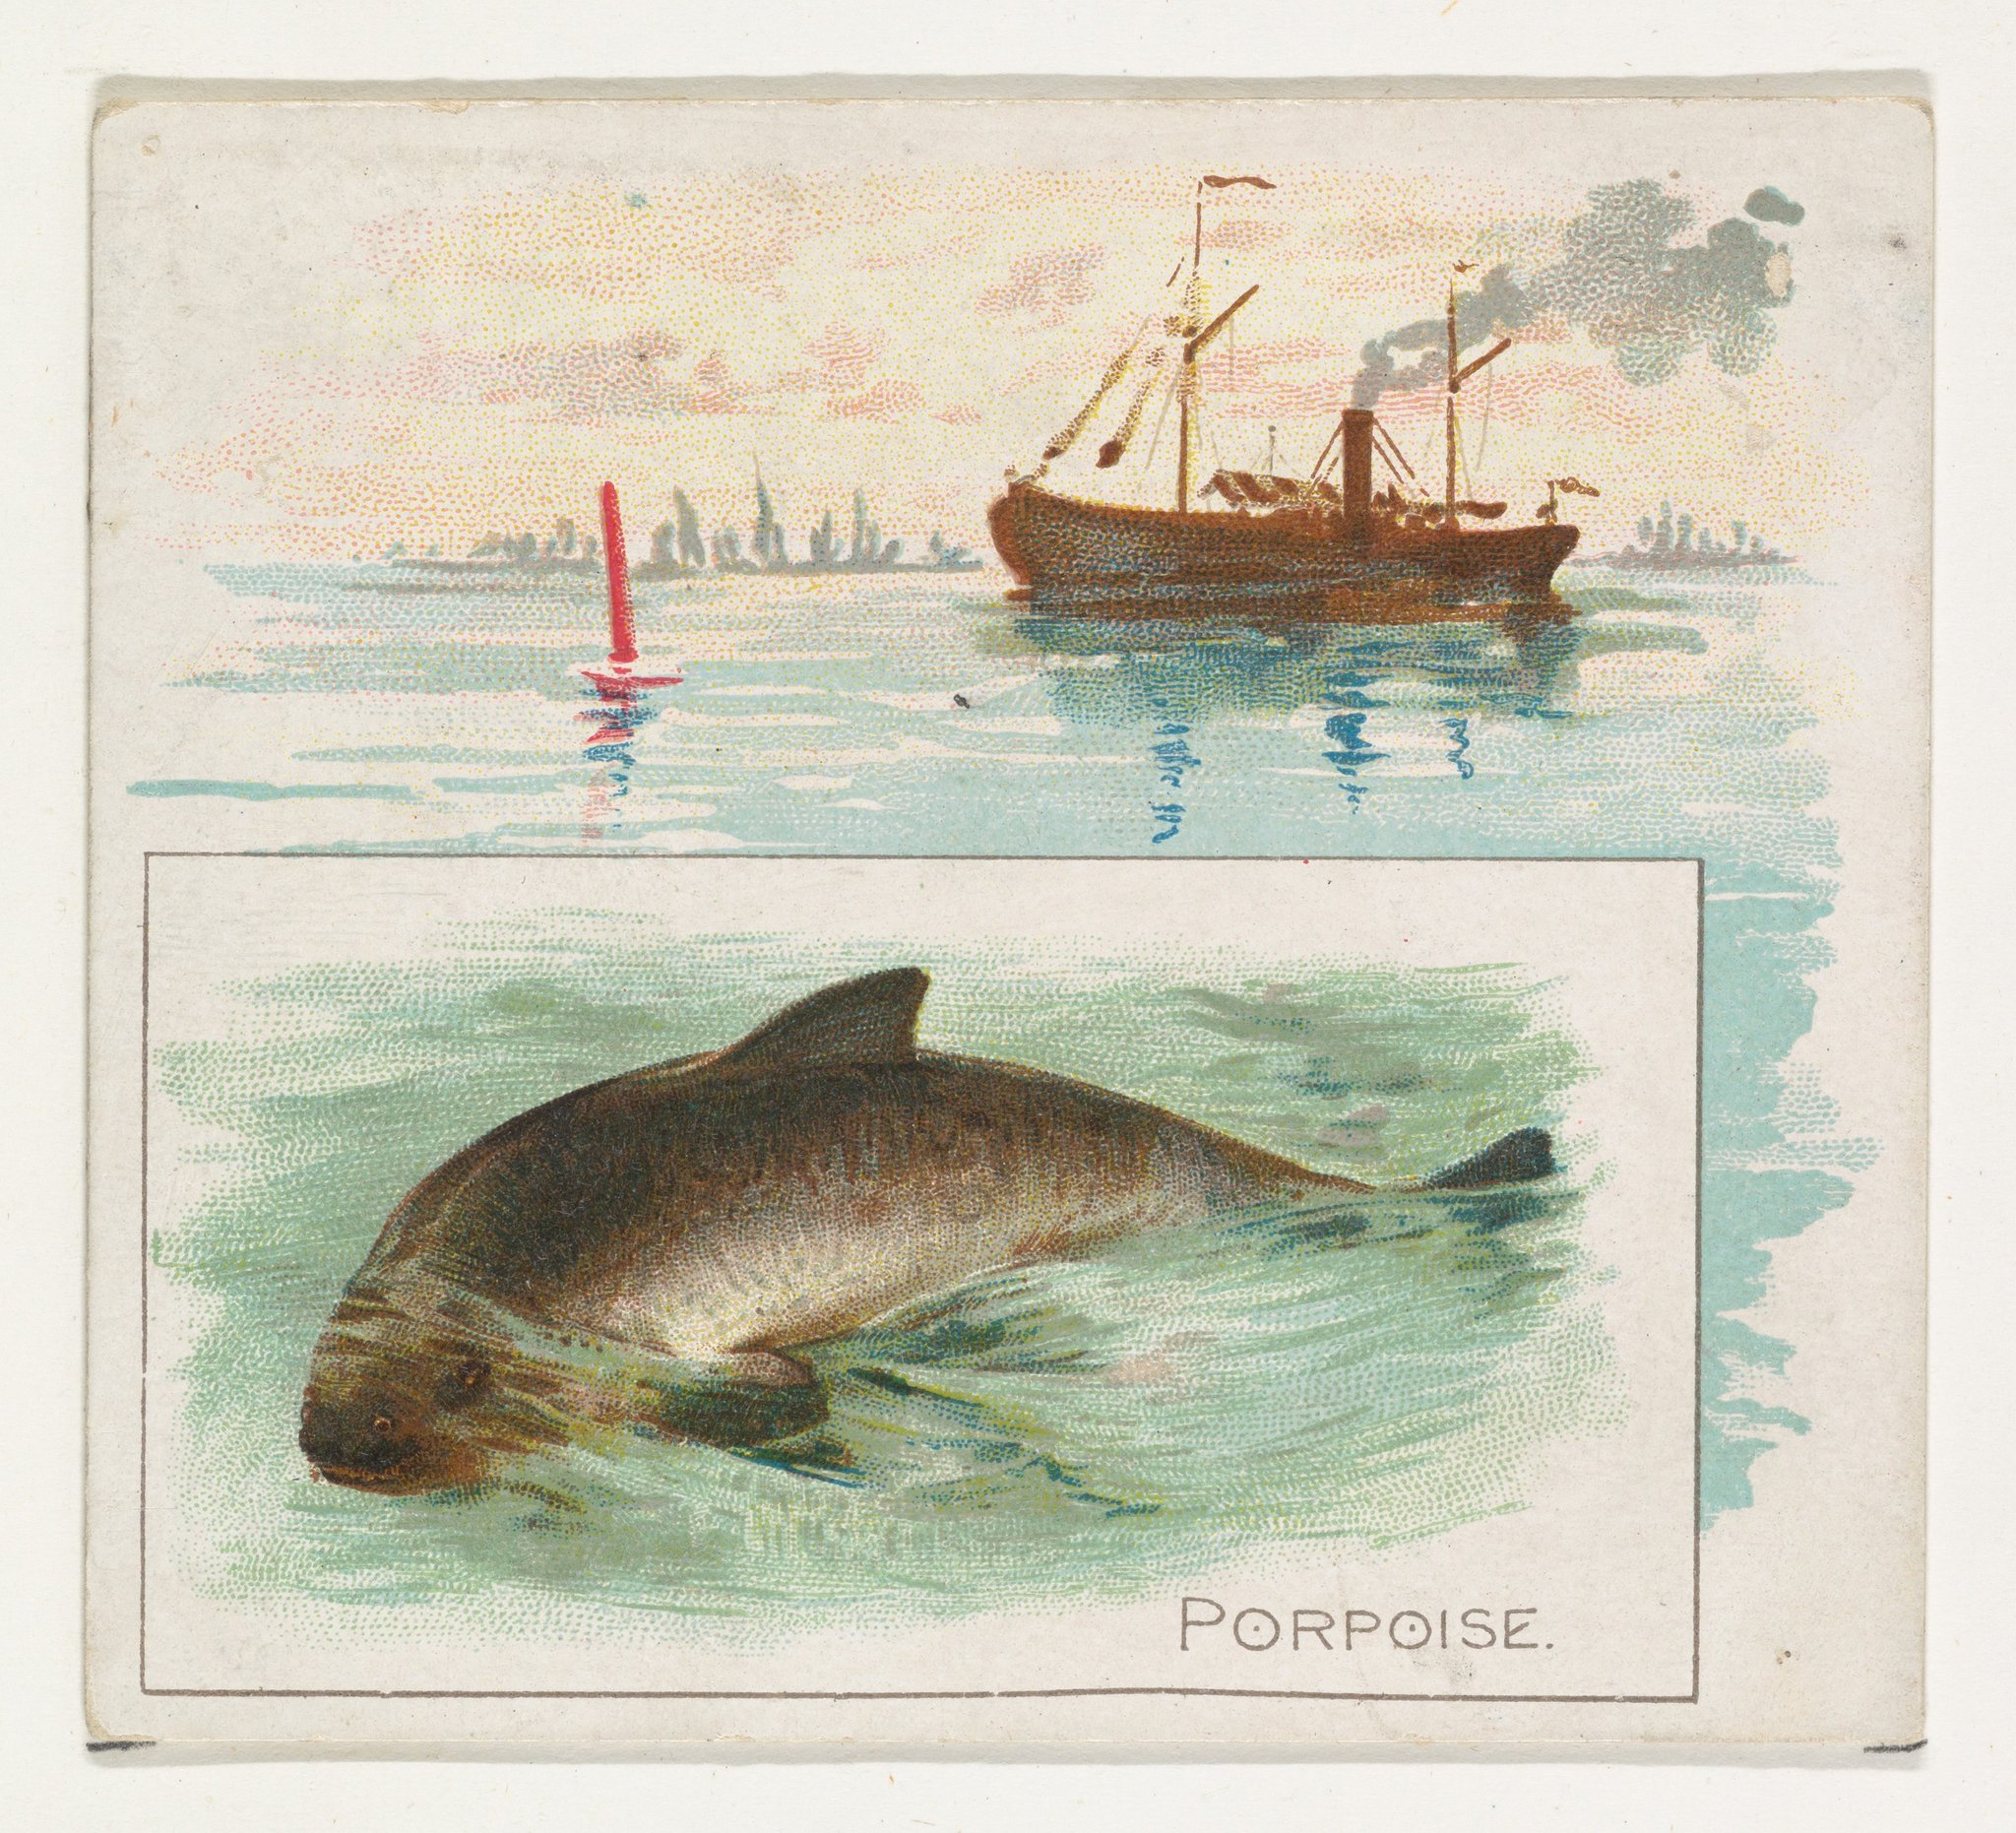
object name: print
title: Porpoise, from Fish from American Waters series (N39) for Allen & Ginter Cigarettes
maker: allen & ginter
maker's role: publisher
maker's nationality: american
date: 1889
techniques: color lithograph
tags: fish,ships